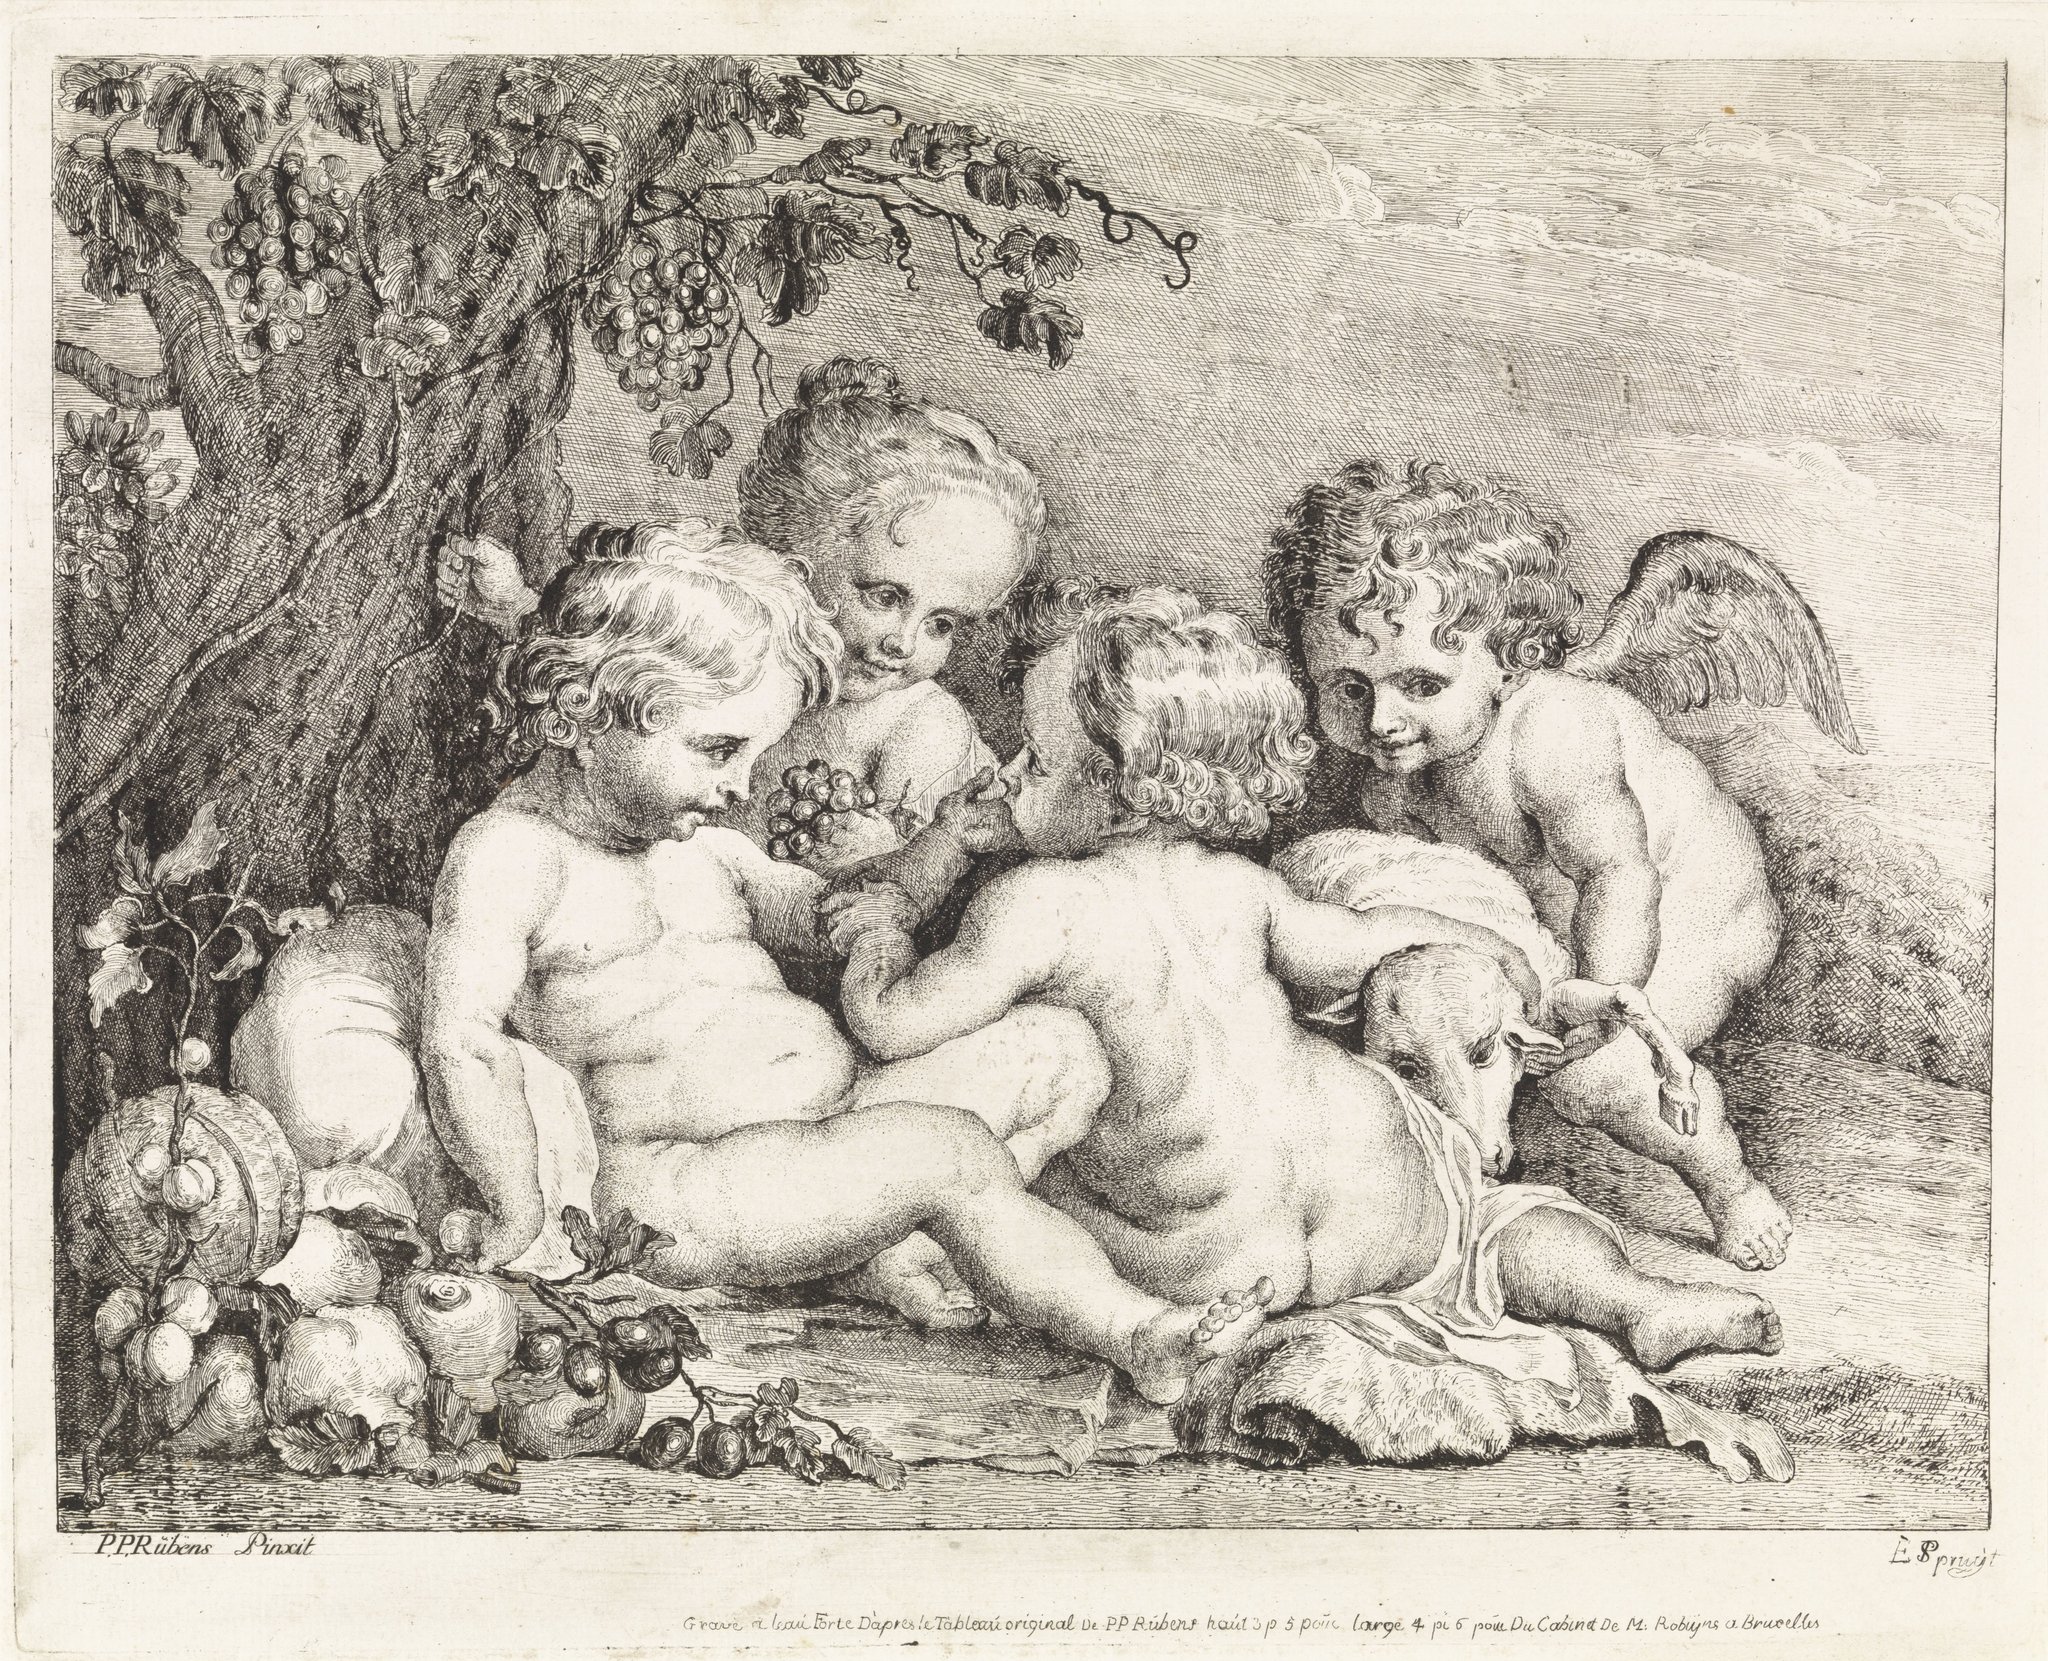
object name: print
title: Christus, Johannes de Doper en twee putti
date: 1747-1801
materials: paper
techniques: etching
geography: ghent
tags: vine, lamb, cupids: 'amores', 'amoretti', 'putti'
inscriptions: collector's mark: Lugt 240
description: Christus en Johannes de Doper zitten als kinderen, vergezeld door twee putti, onder een wijnrank met een lam. Links op de voorgrond liggen vruchten.